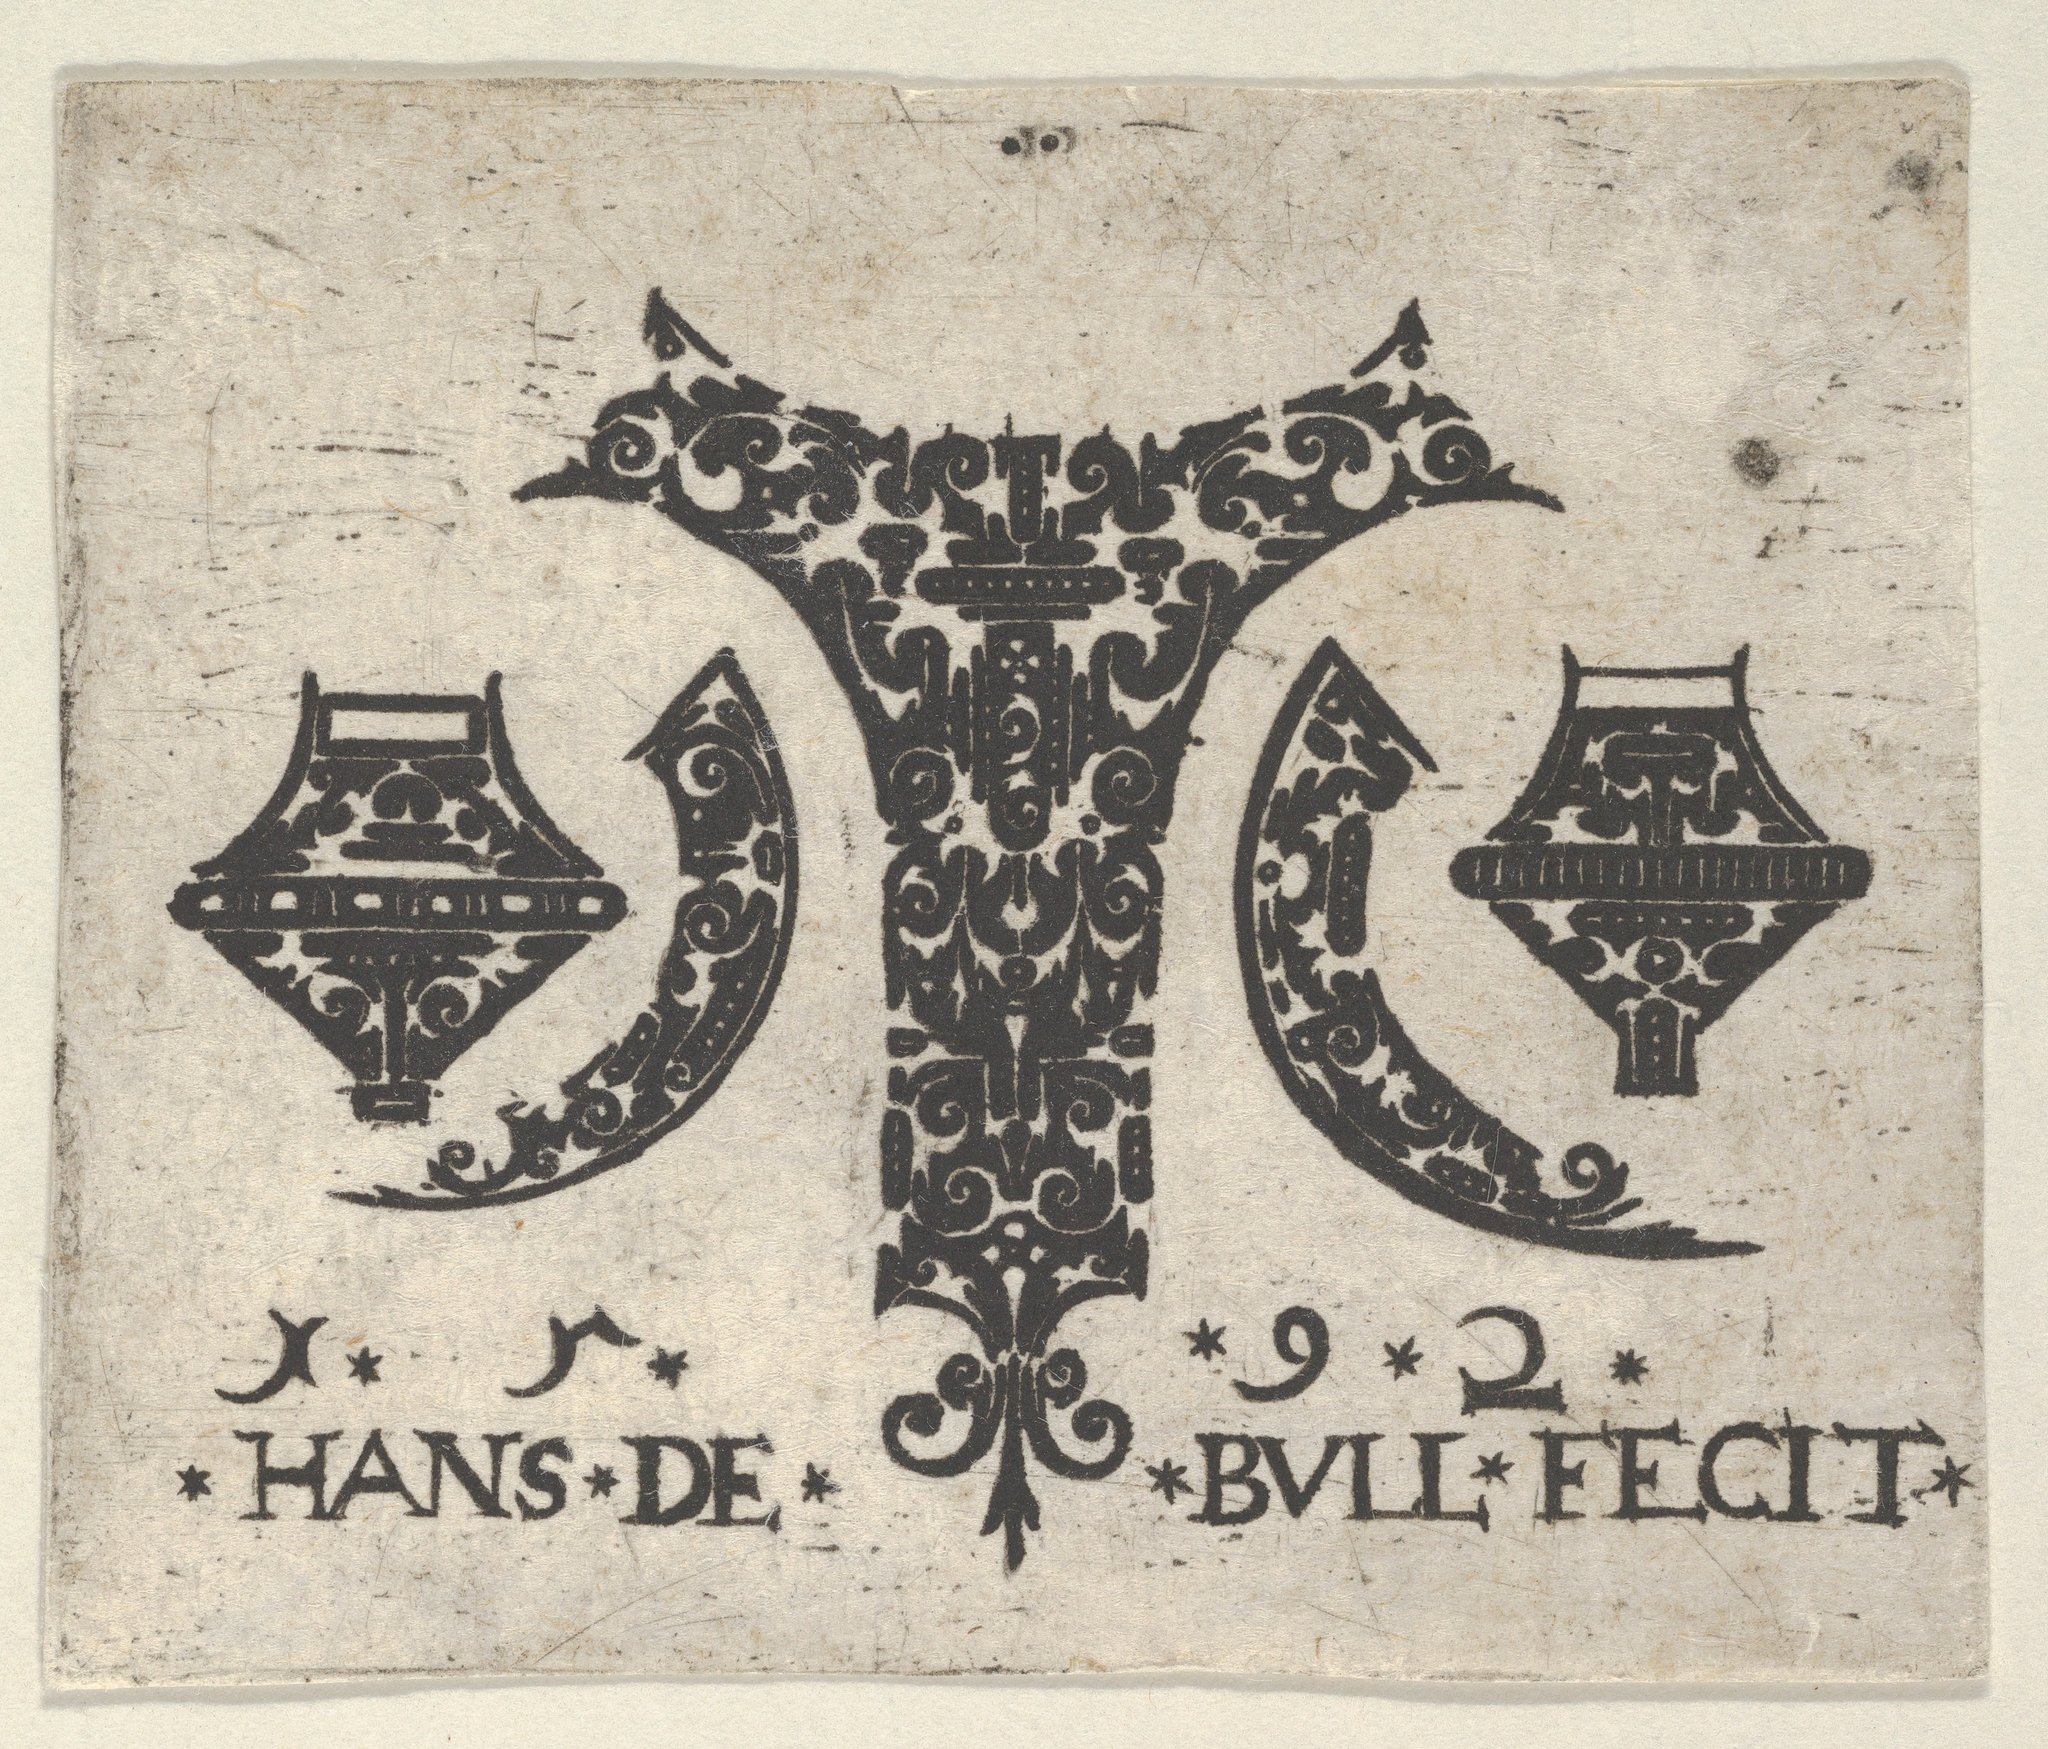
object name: print ornament architecture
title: Blackwork Print with Design for a Ring Shoulder and Bezel Flanked by Pairs of Fillets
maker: hans de bull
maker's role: artist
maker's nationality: german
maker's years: 1592-1604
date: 1592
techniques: embroidery, engraving